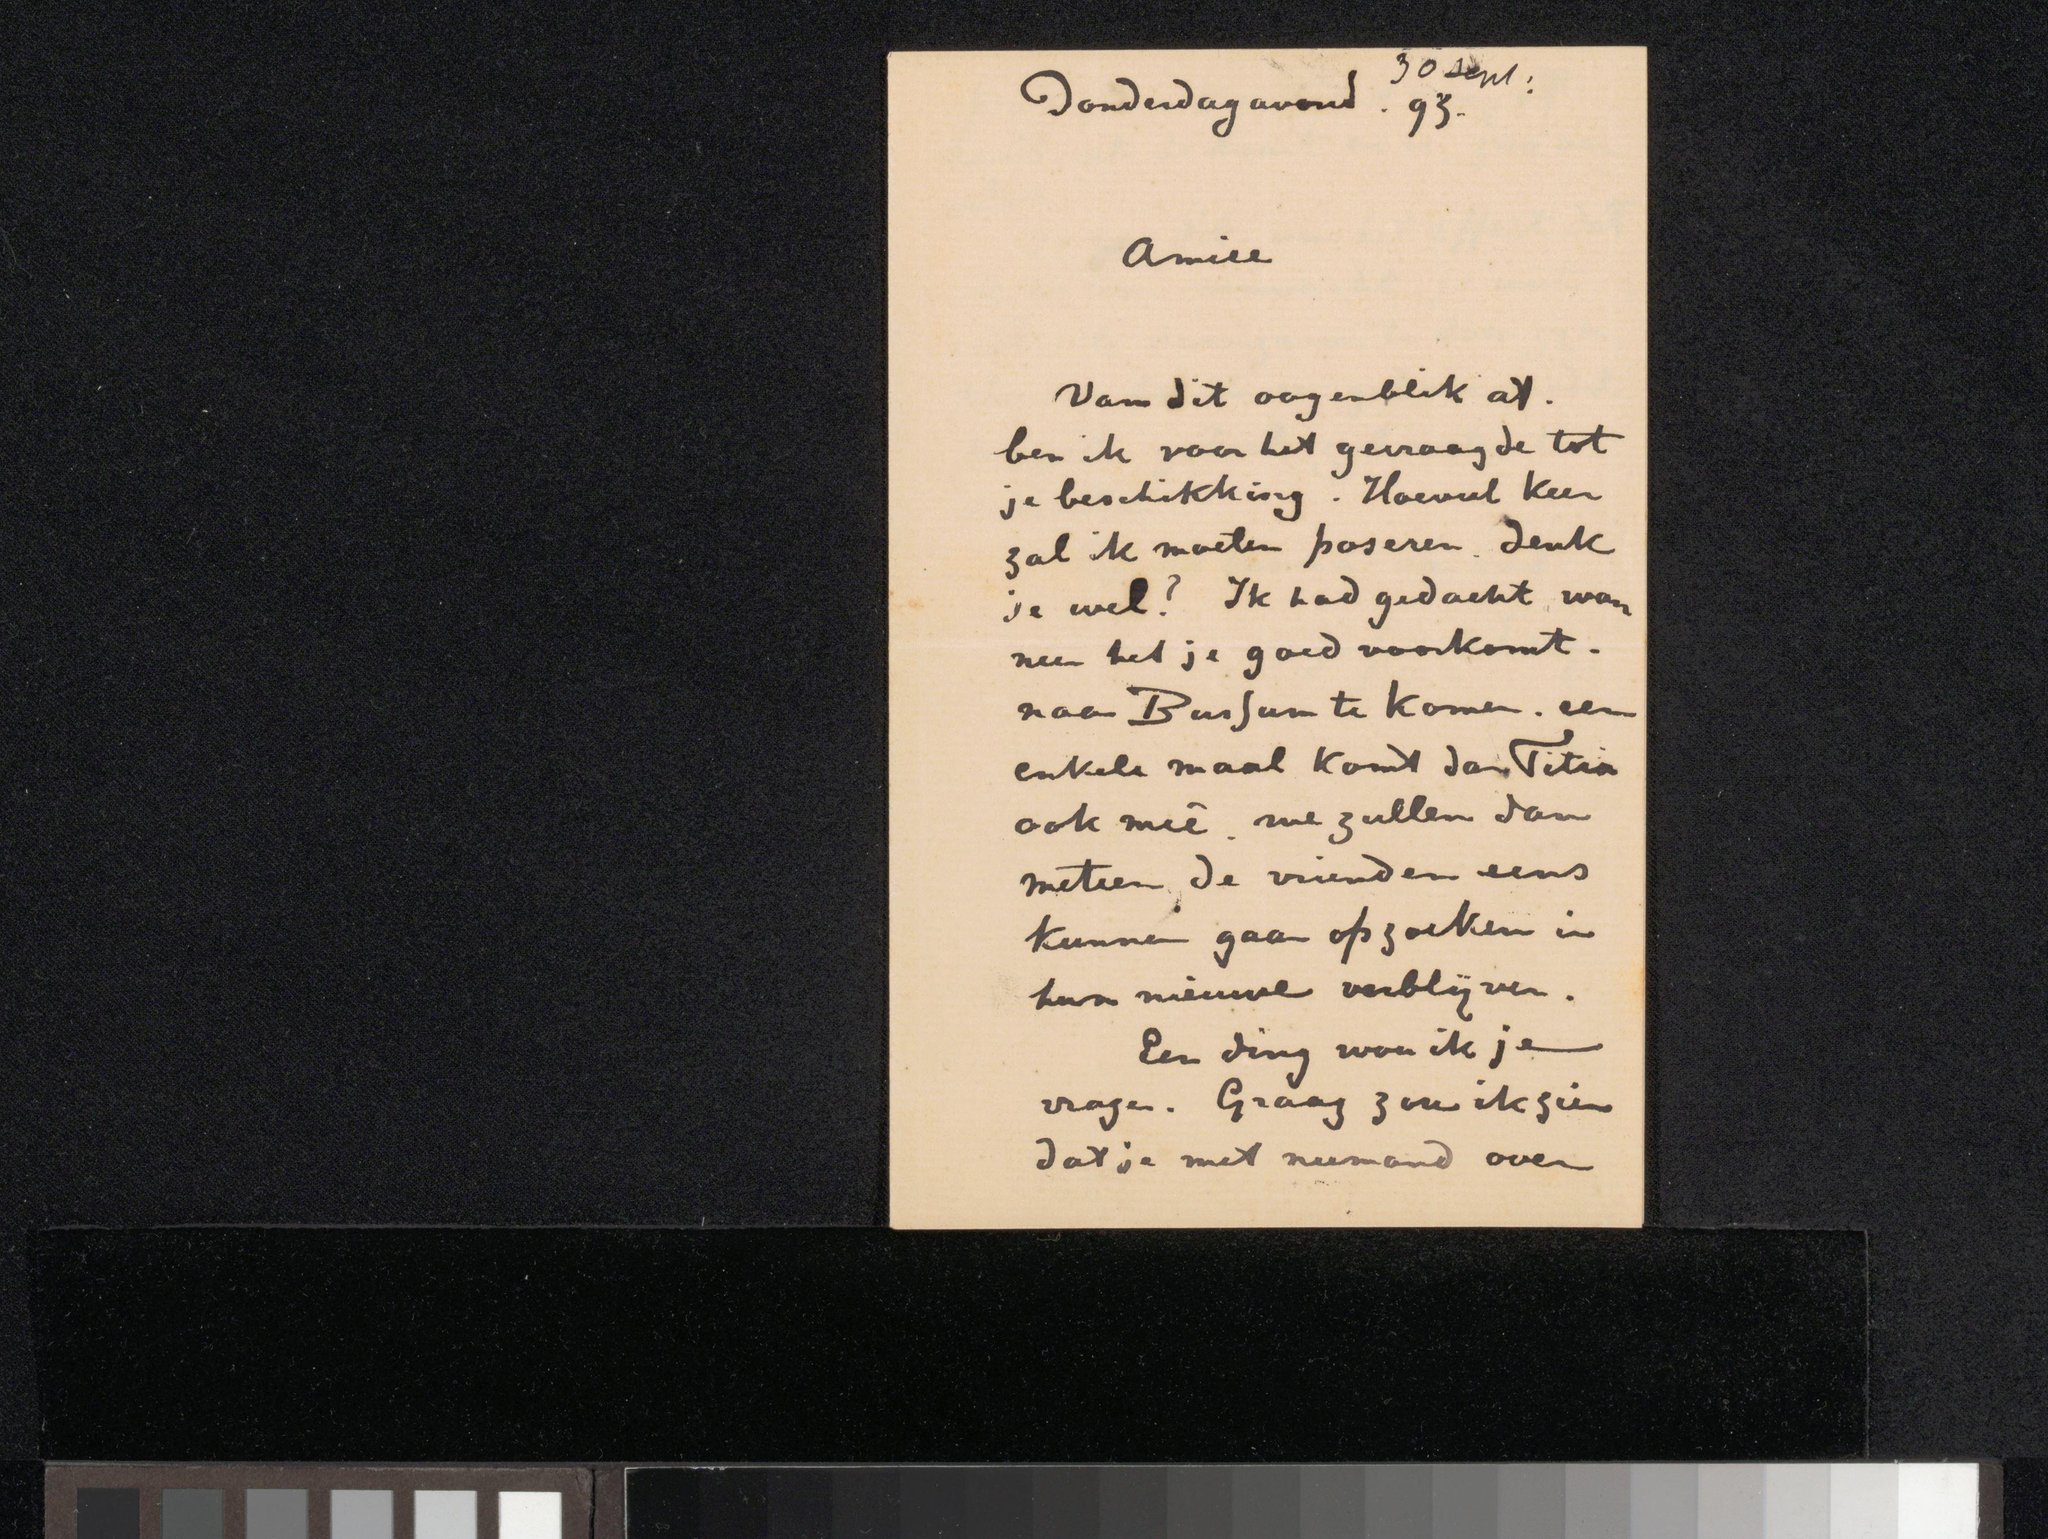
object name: letter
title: Brief aan Jan Veth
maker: jac van looij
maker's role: draughtsman, painter, print maker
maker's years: 1855-1930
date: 1893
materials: ink, paper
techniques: pen, writing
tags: dordrecht, amsterdam, designer, jan veth, historical persons (portraits and scenes from the life)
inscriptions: collector's mark: ‘RPK’